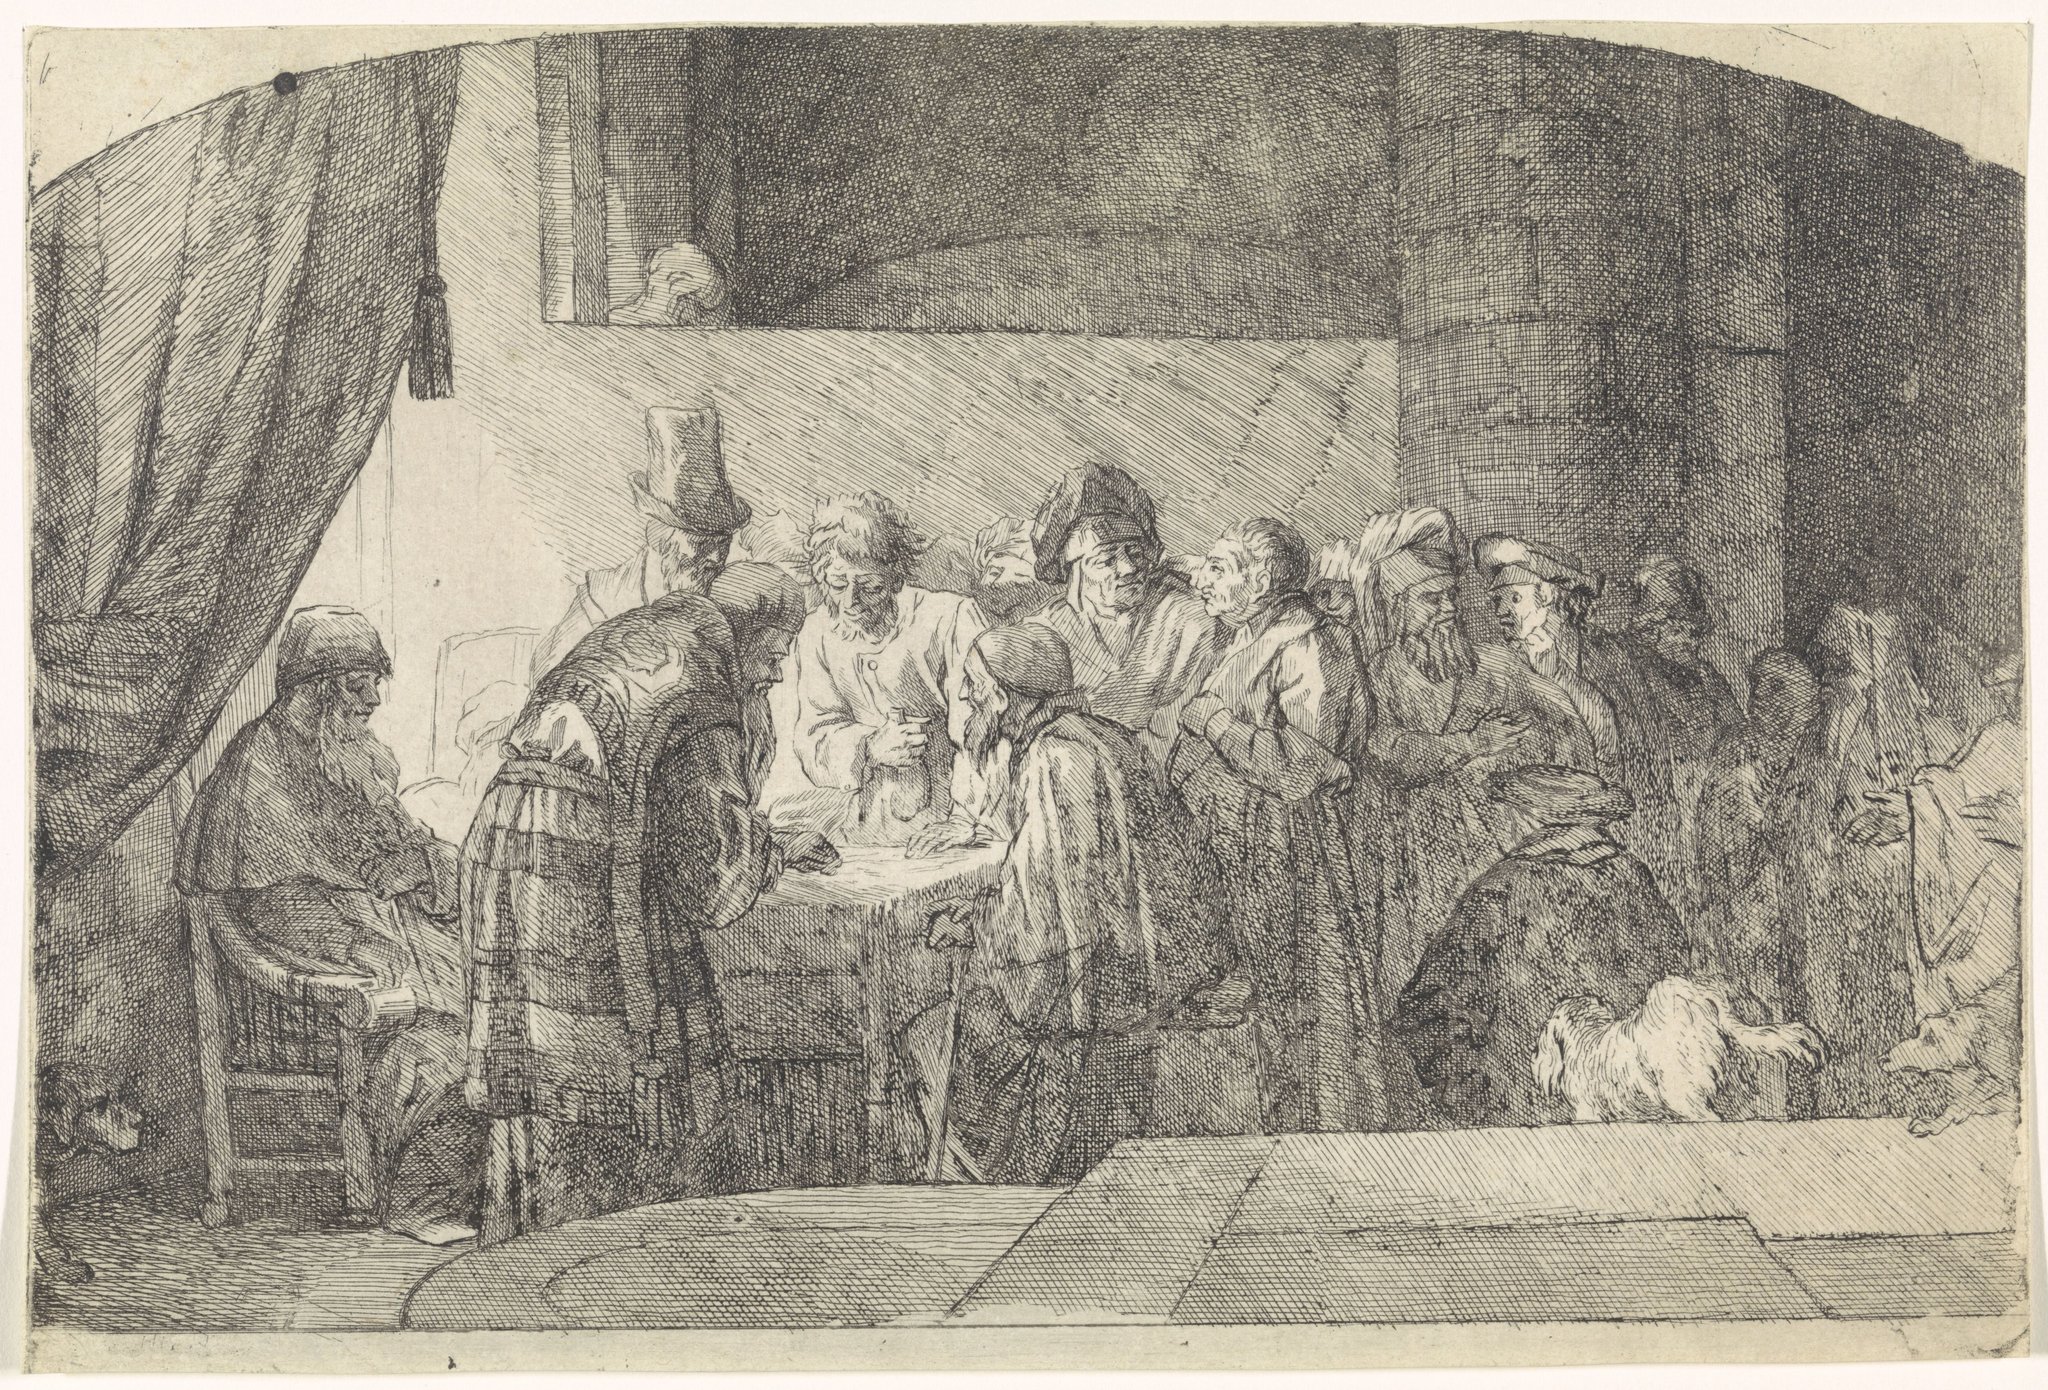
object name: print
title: Judas ontvangt zilverstukken voor zijn verraad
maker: bernard picart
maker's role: draughtsman, print maker, publisher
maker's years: 1673-1733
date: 1683-1733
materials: paper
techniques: etching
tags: judas goes out to the chief priests, betrays christ and receives the reward (matthew 26:14-16; mark 14:10-11; luke 22:4-6)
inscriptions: collector's mark: Lugt 240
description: Definitieve geletterde staat van deze prent opgenomen in: Impostures innocentes, ou recueil d'estampes d'apres divers peintres (...) par Bernard Picart (...) avec son elogue historique et le catalogue de ses ouvrages. Amsterdam: weduwe Bernard Picart, 1734.